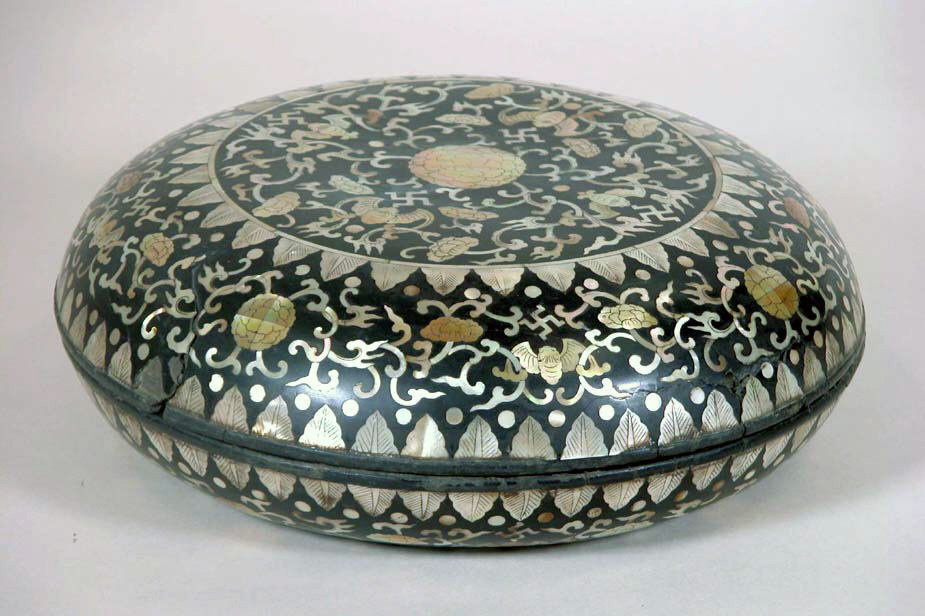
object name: round box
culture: chinese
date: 1368-1644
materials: lacquer, mother of pearl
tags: flowers,leaves